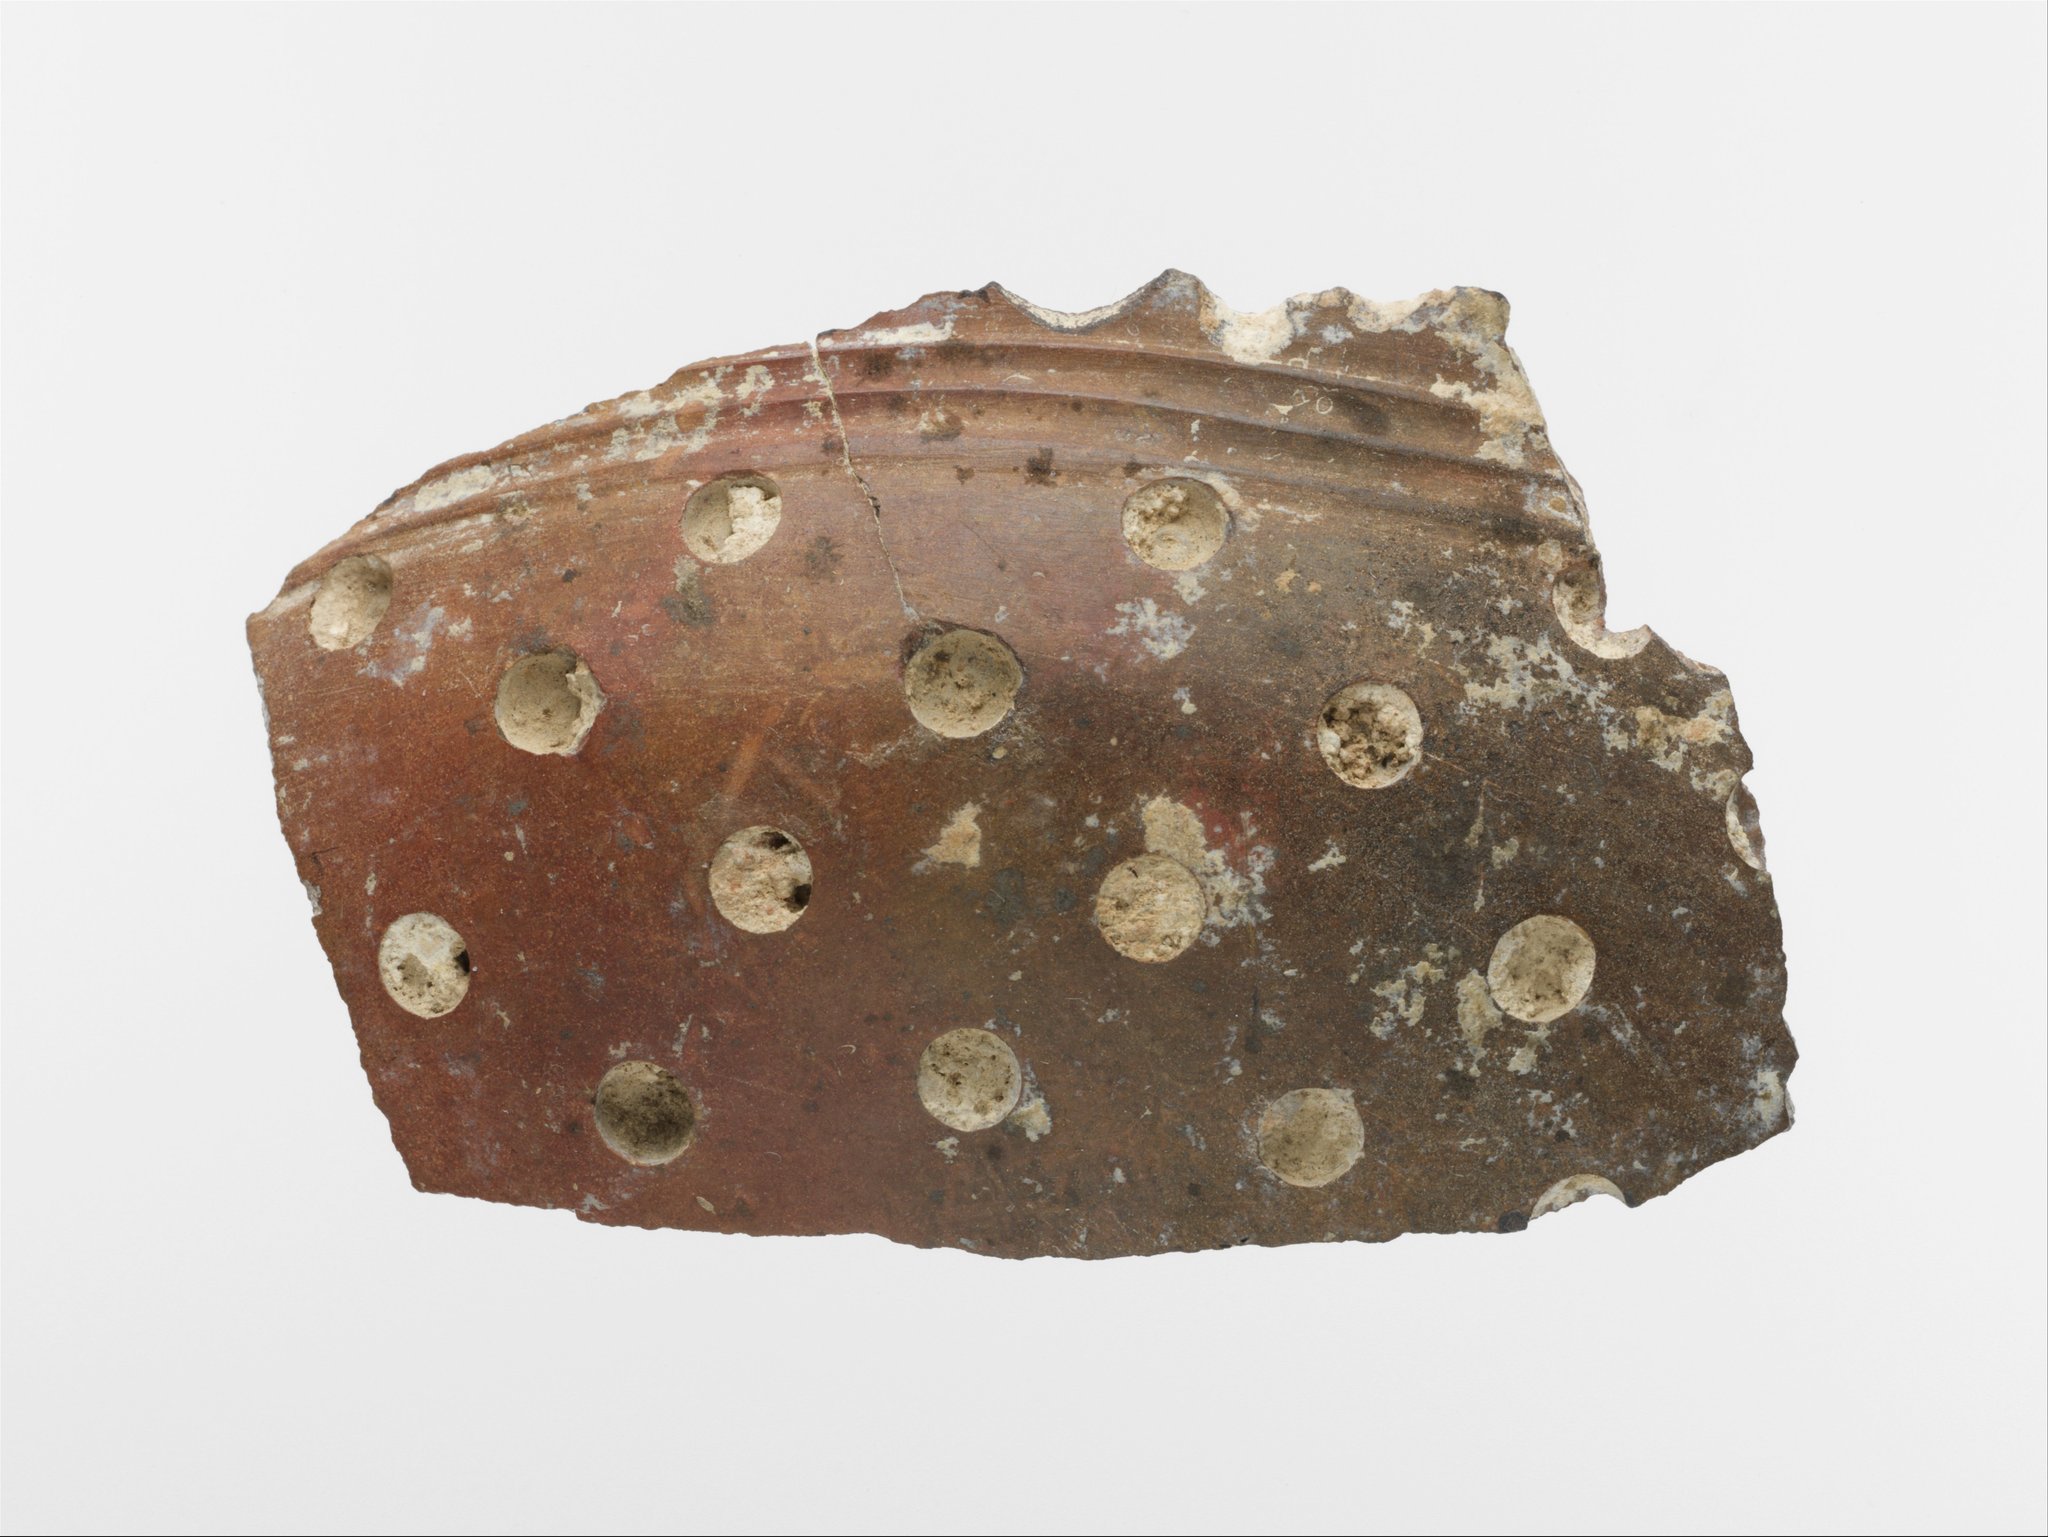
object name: vase fragment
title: Terracotta vase fragment with white inlay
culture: minoan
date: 1800-1700 BCE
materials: terracotta